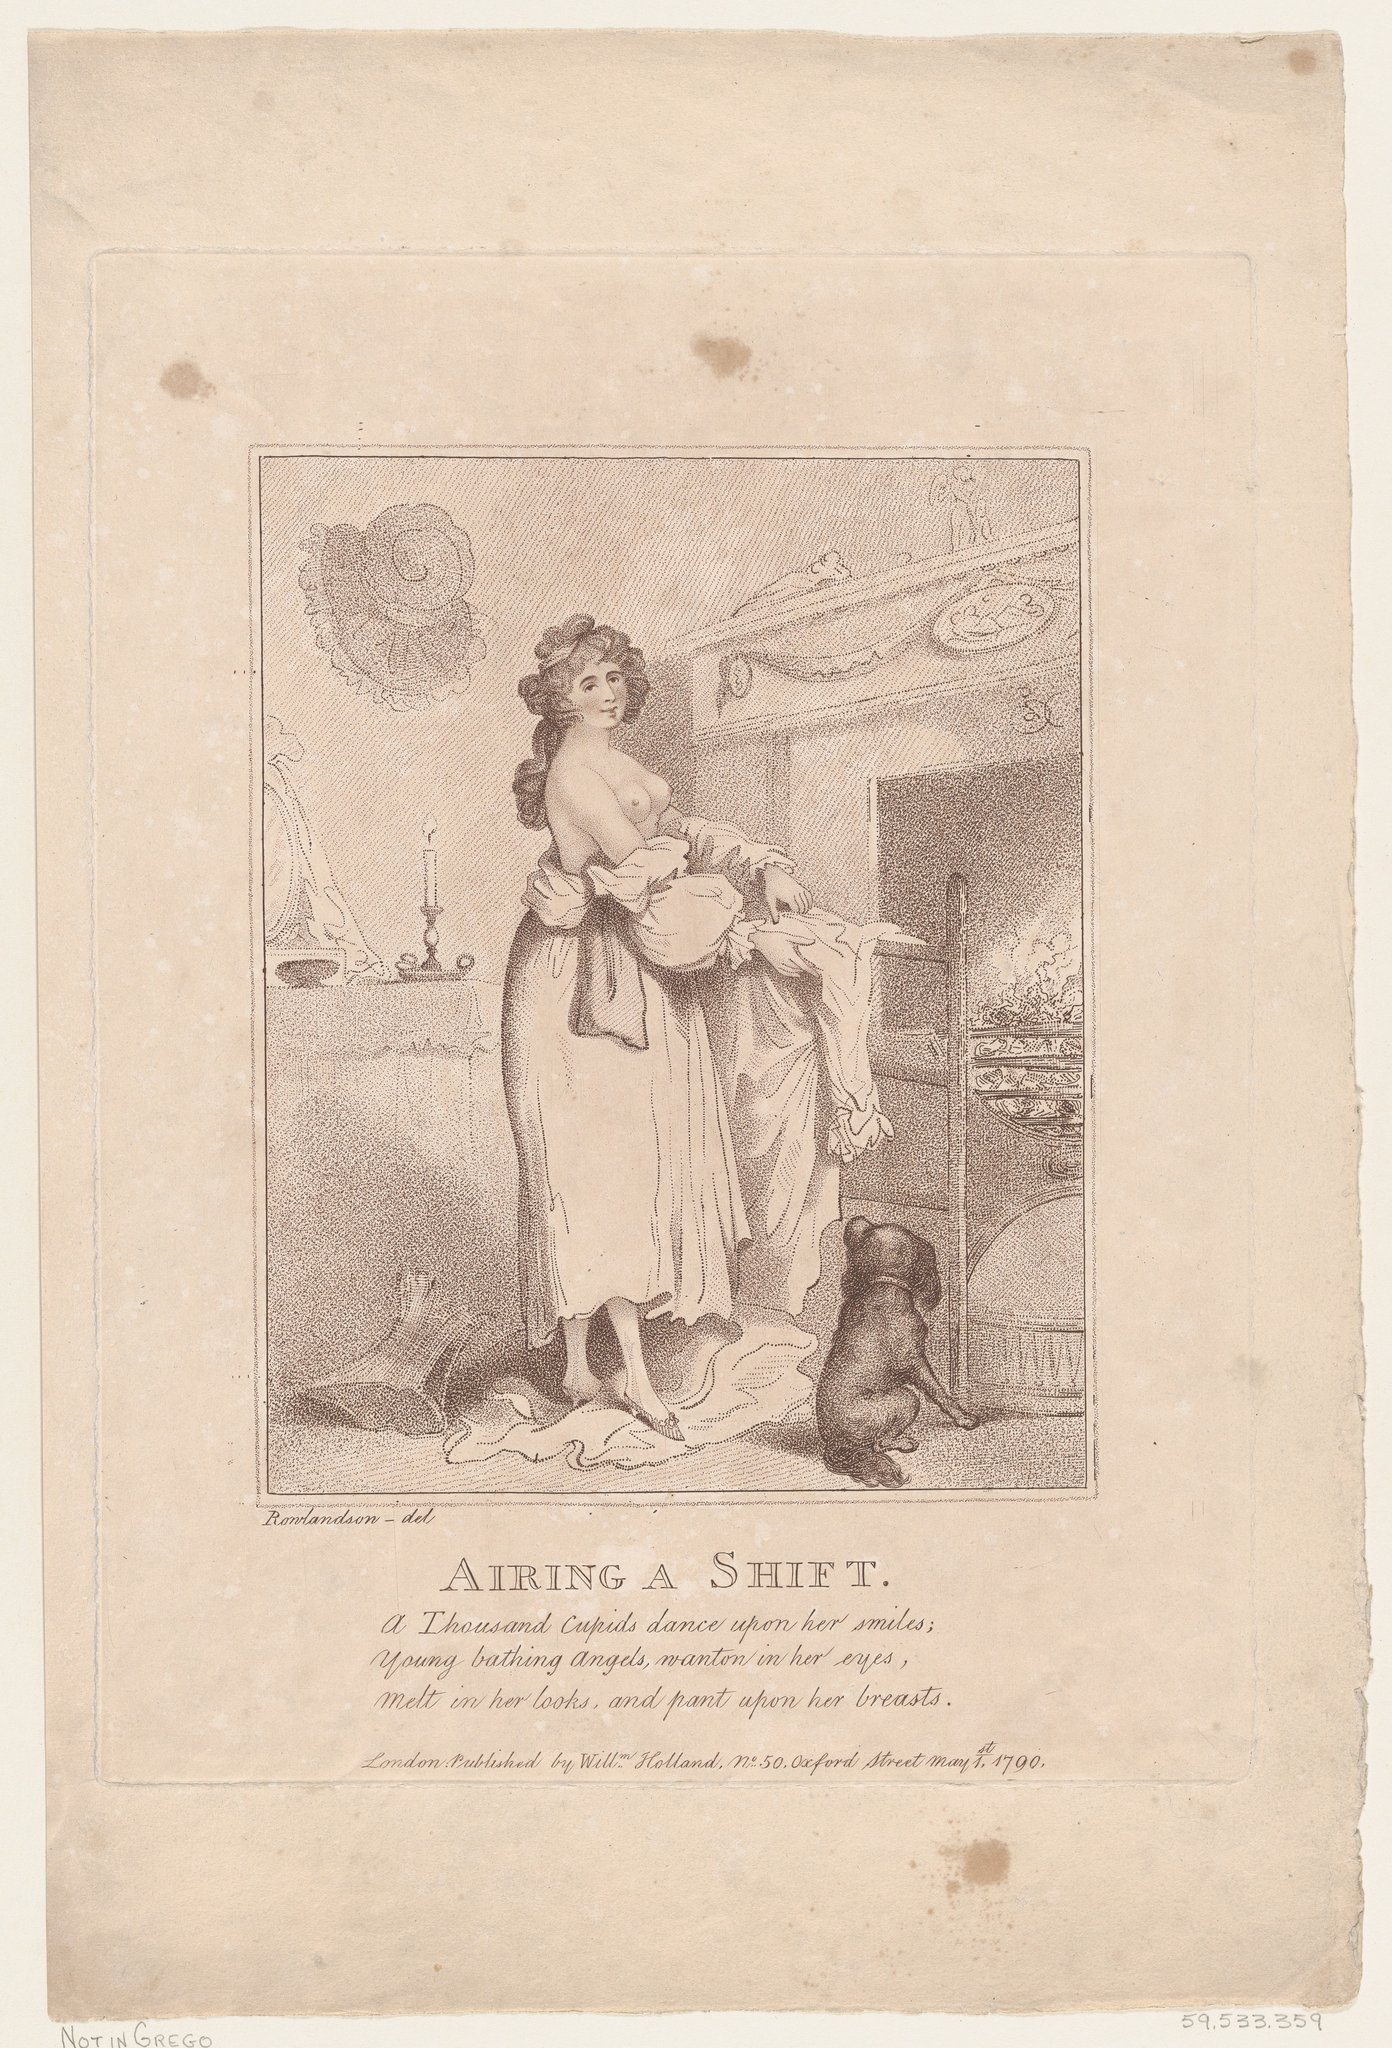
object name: print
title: Airing a Shift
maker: thomas rowlandson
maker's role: artist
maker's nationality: british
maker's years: 1757-1827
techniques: etching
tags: interiors,female nudes,dogs